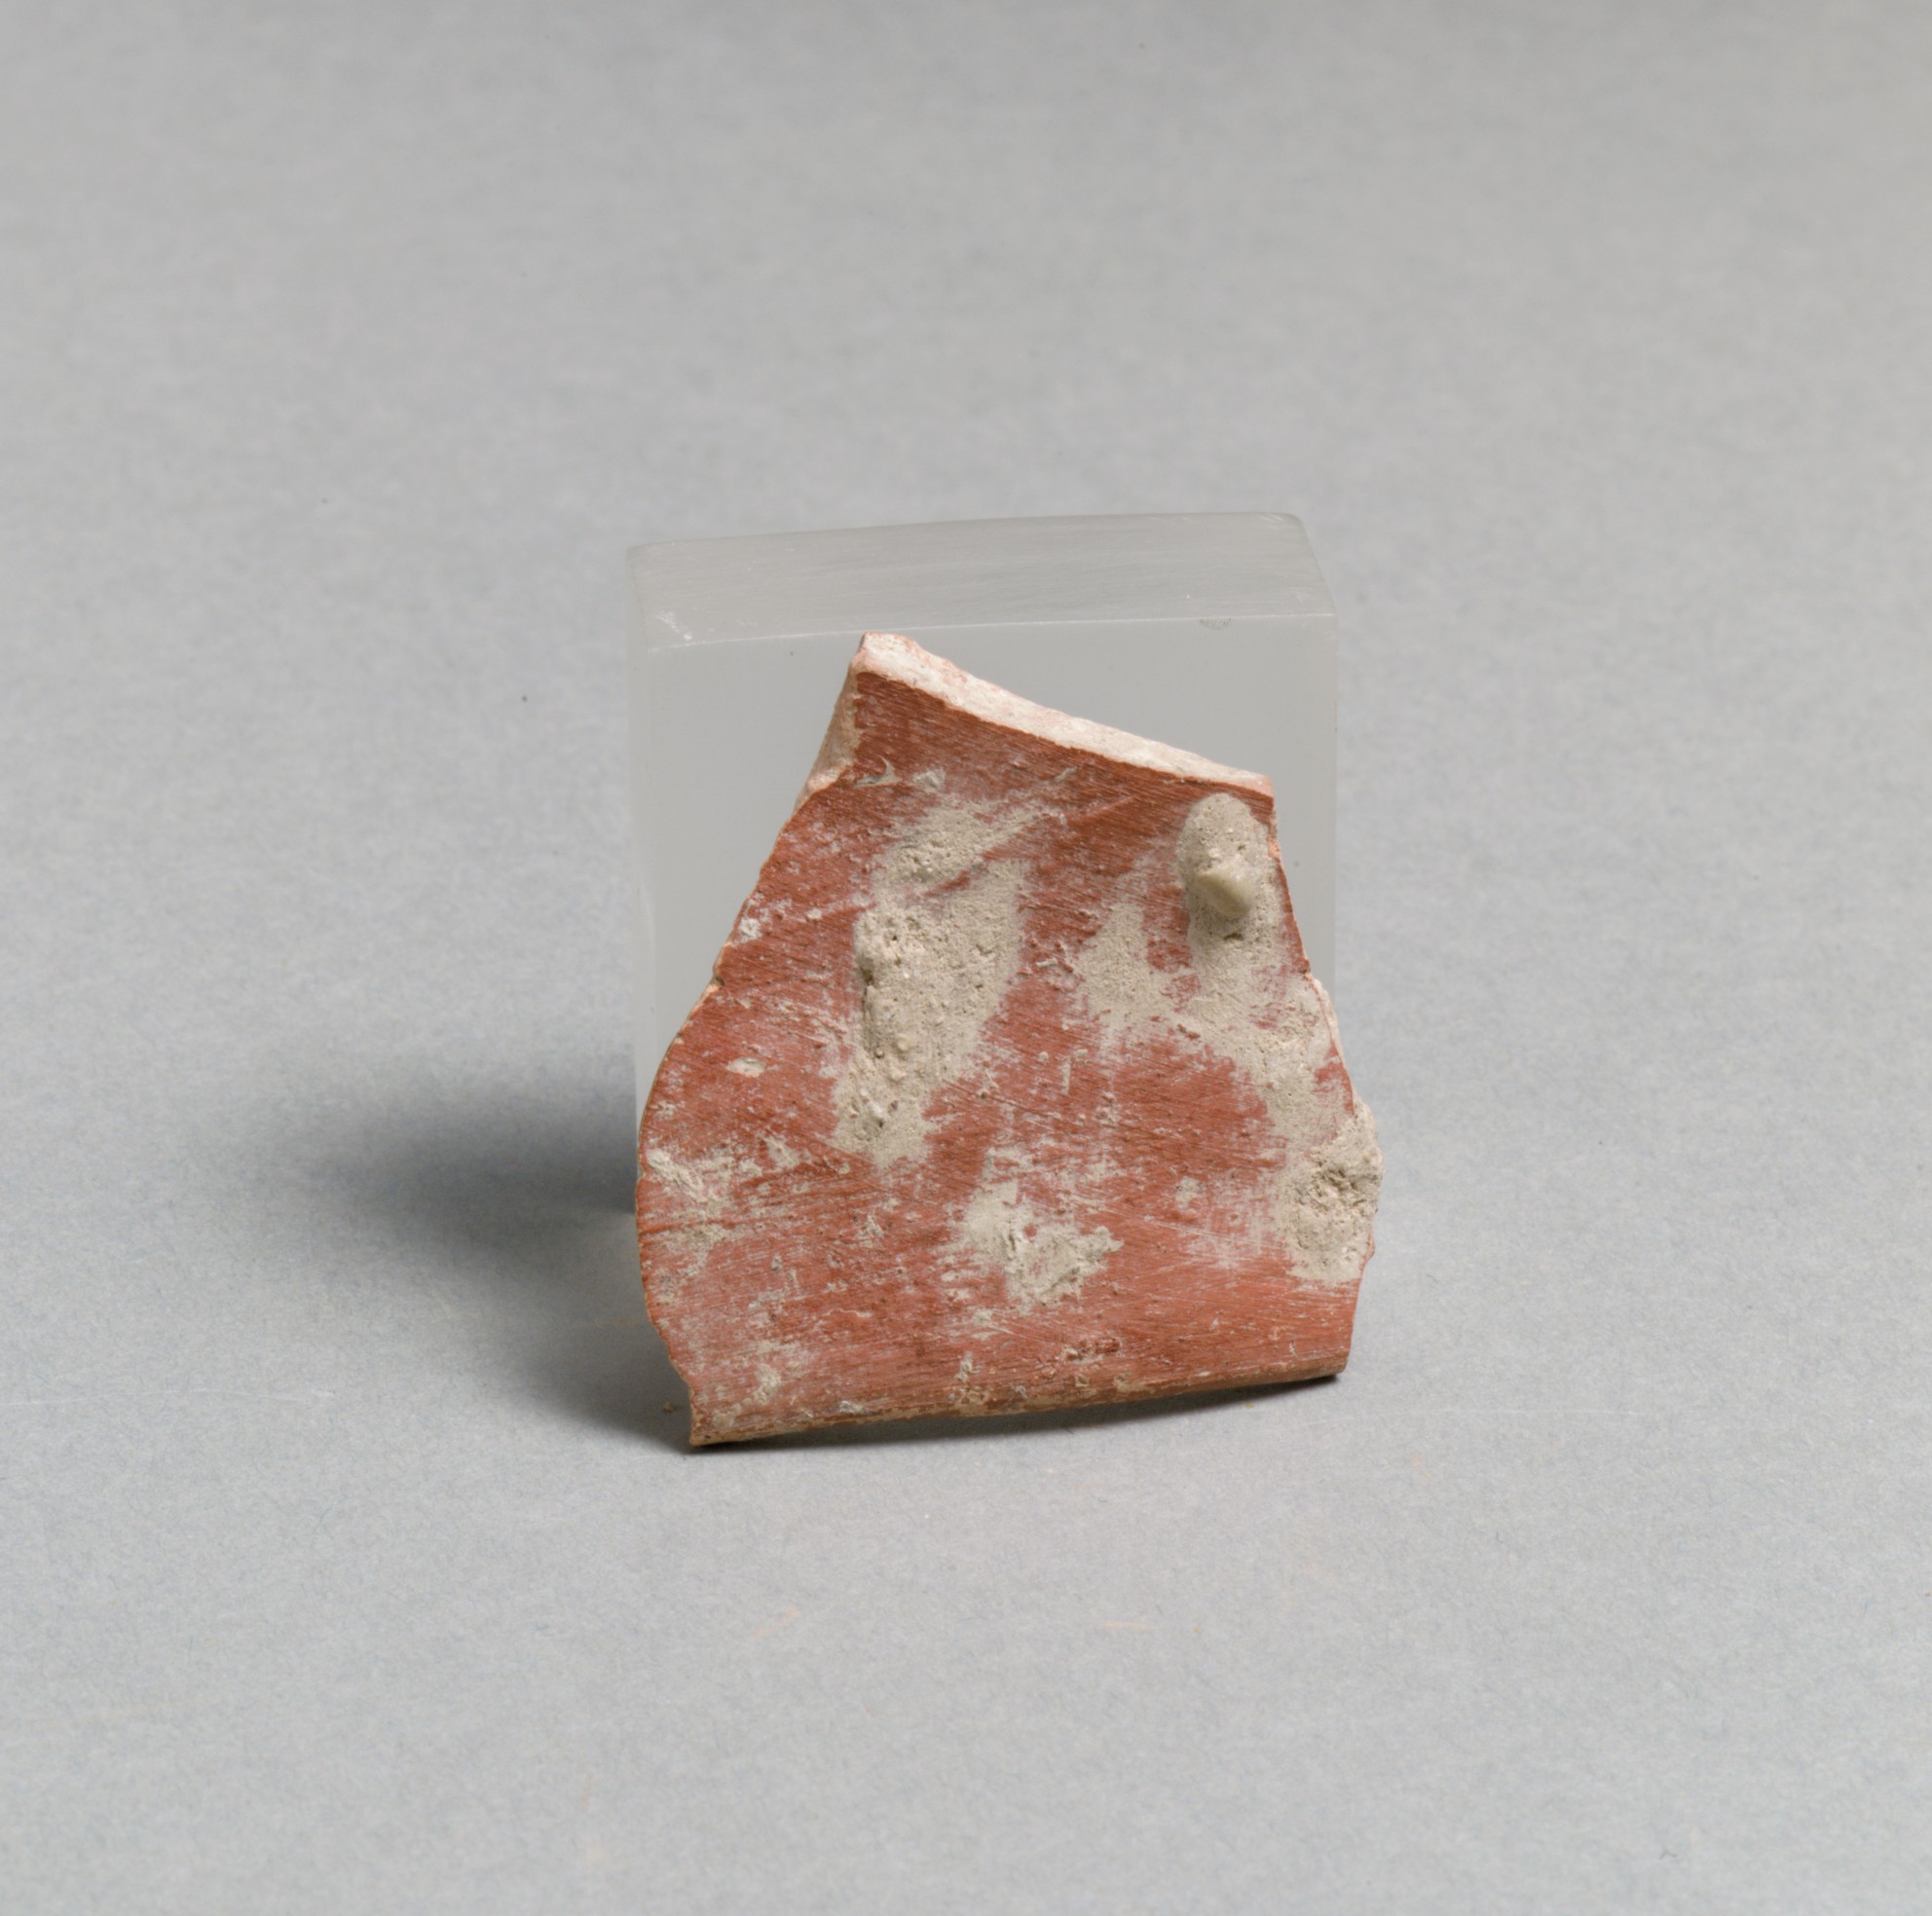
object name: vase fragment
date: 3000-2200 BCE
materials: terracotta